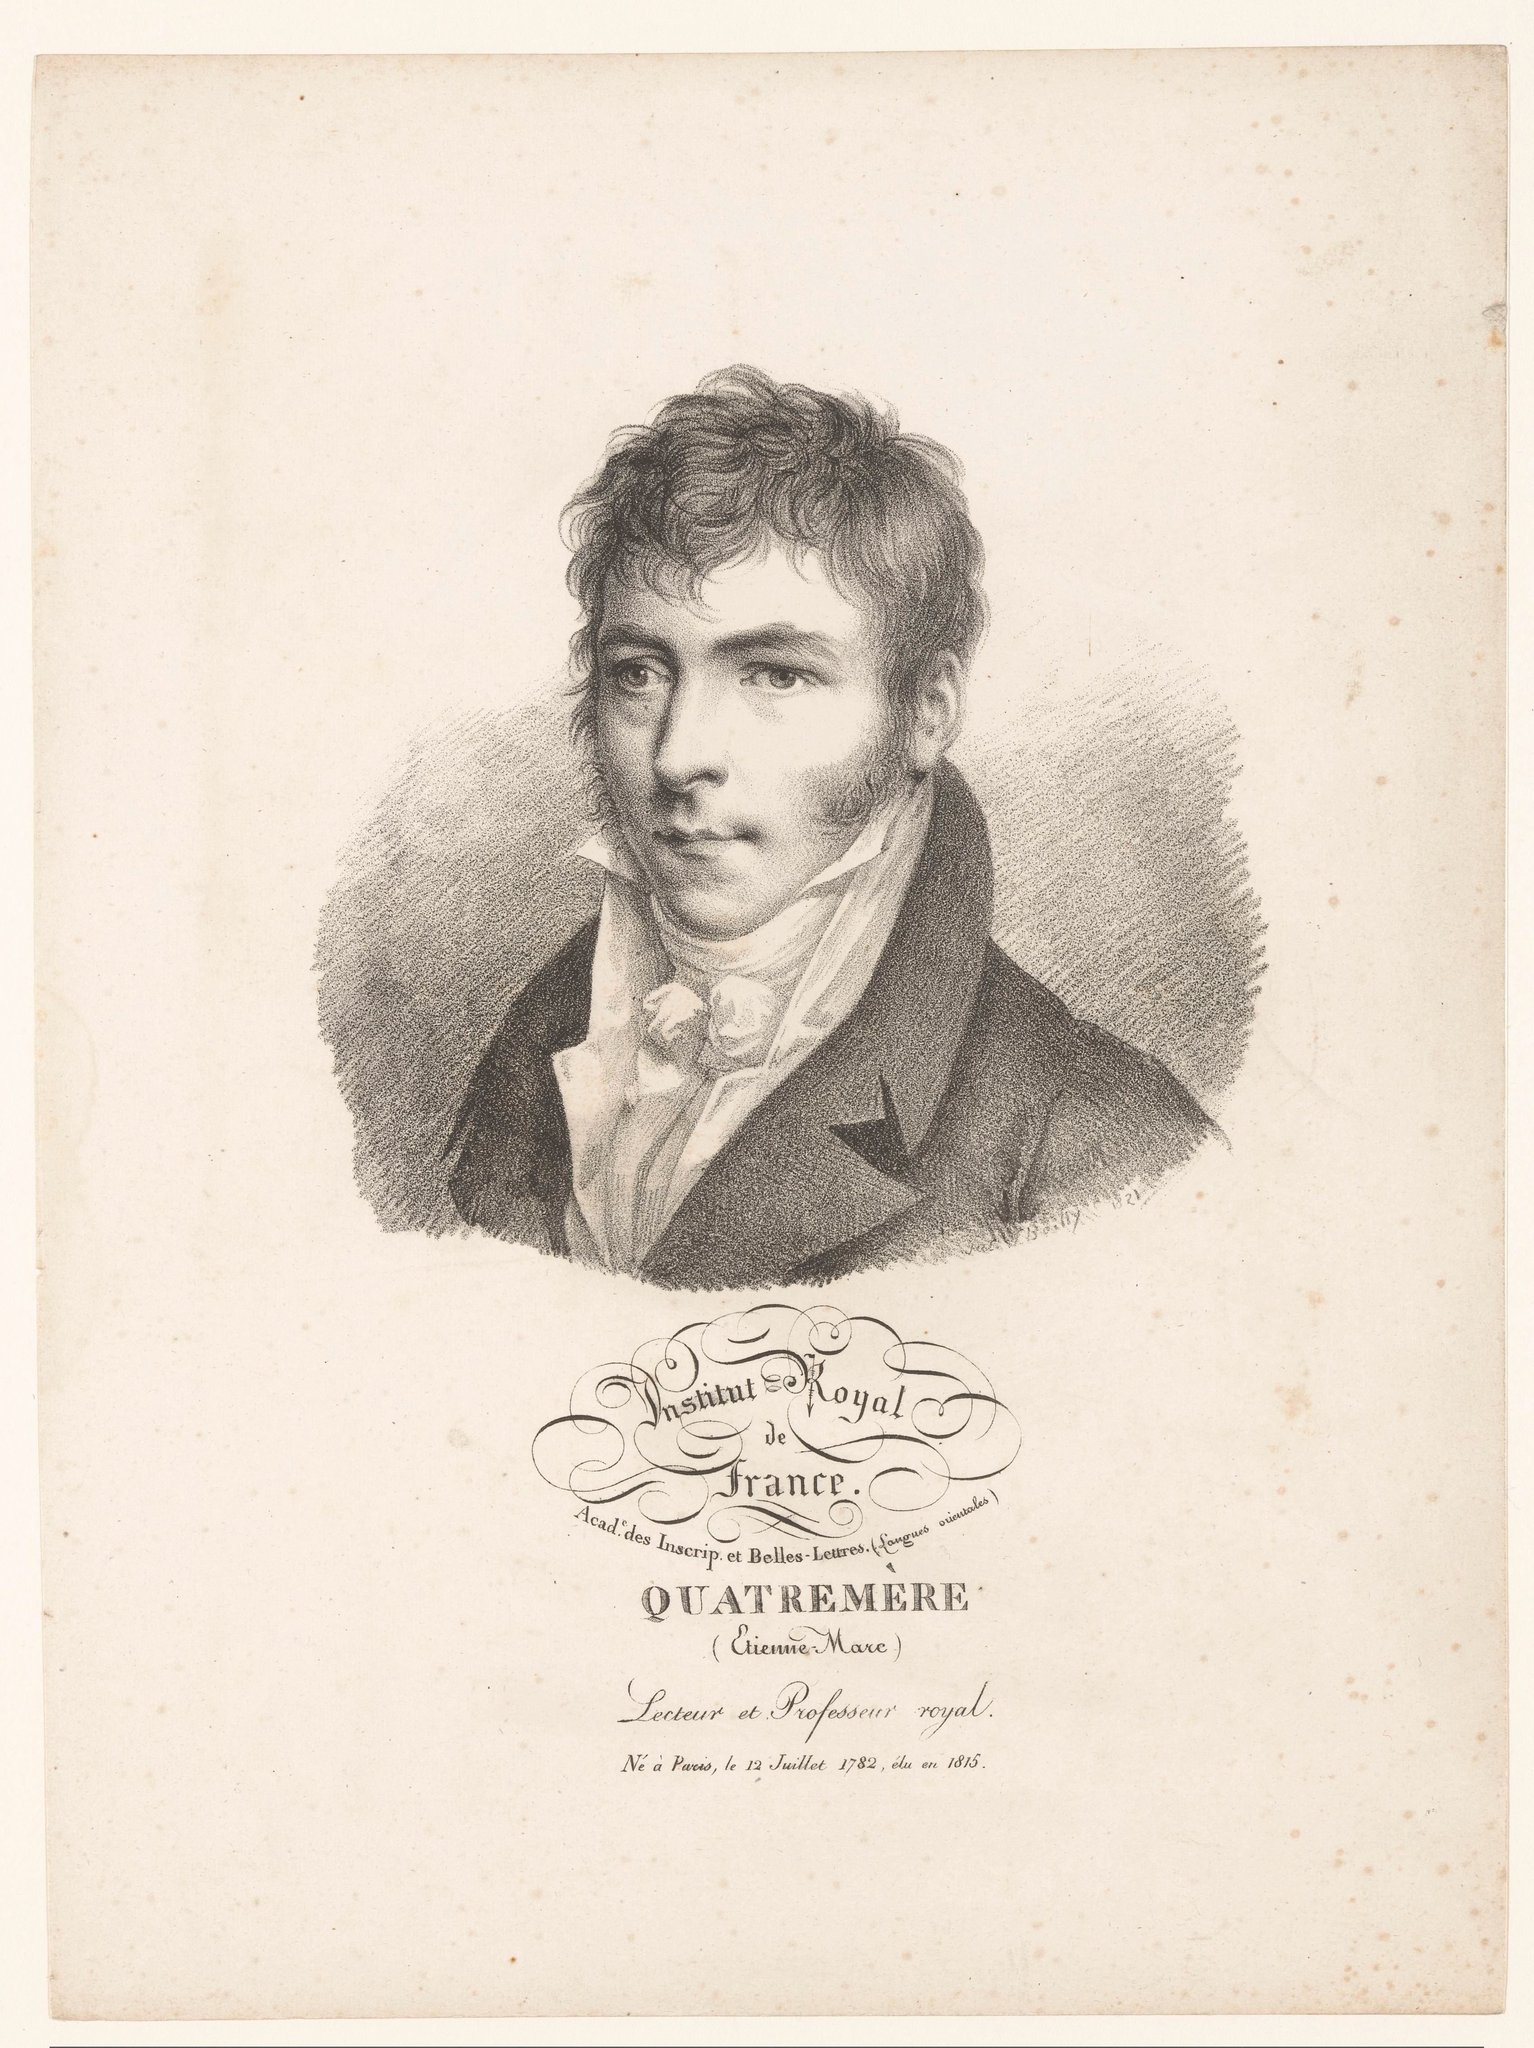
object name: print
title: Portret van de oriëntalist Étienne Marc Quatremère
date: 1821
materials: paper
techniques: lithograph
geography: paris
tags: paris, historical persons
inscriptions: collector's mark: Lugt 2228a